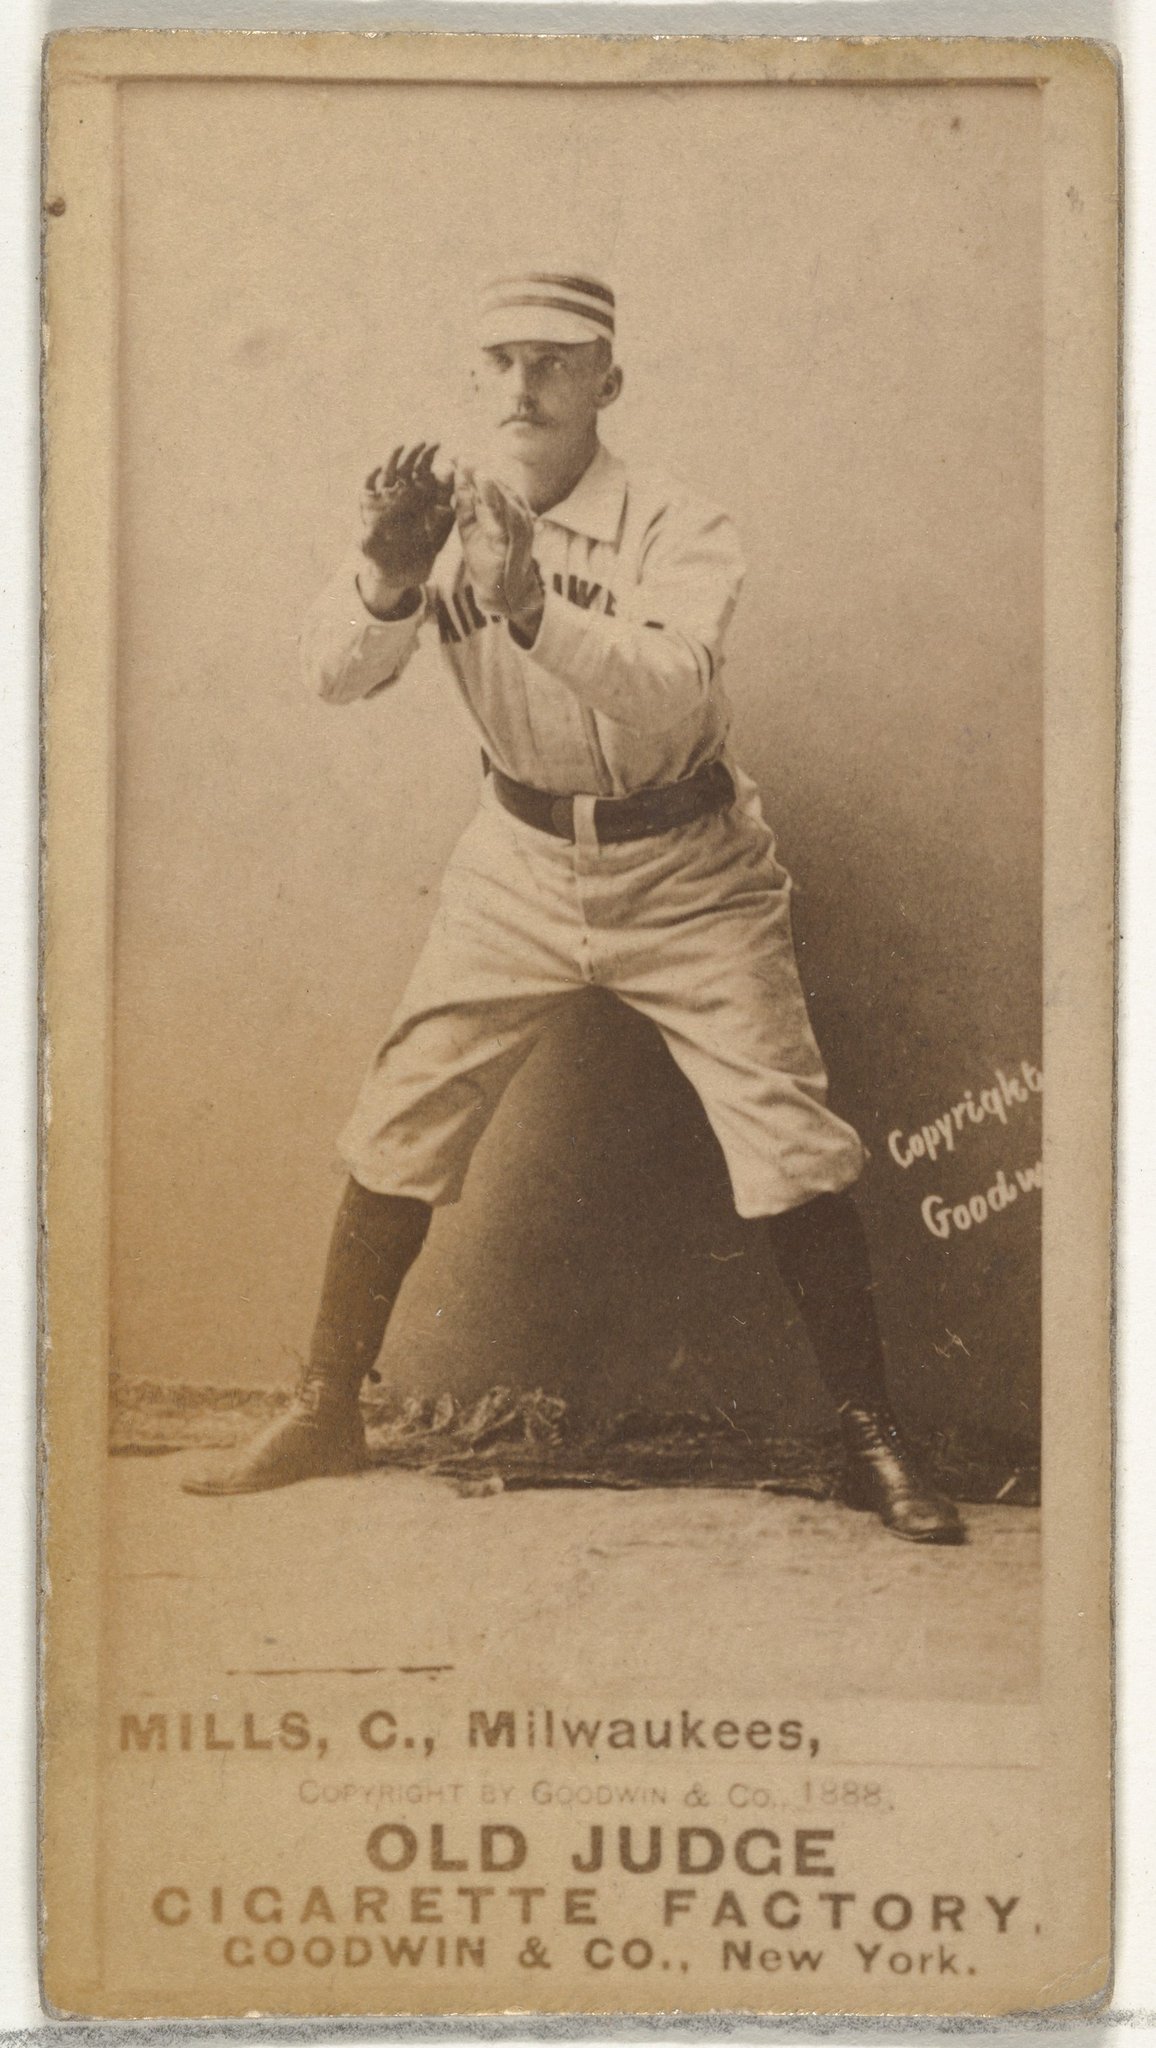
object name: baseball card, photograph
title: Lynn Mills, Catcher, Milwaukee, from the Old Judge series (N172) for Old Judge Cigarettes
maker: goodwin & company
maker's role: publisher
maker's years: 1850-1950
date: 1888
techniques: albumen silver print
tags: men,portraits,baseball,athletes